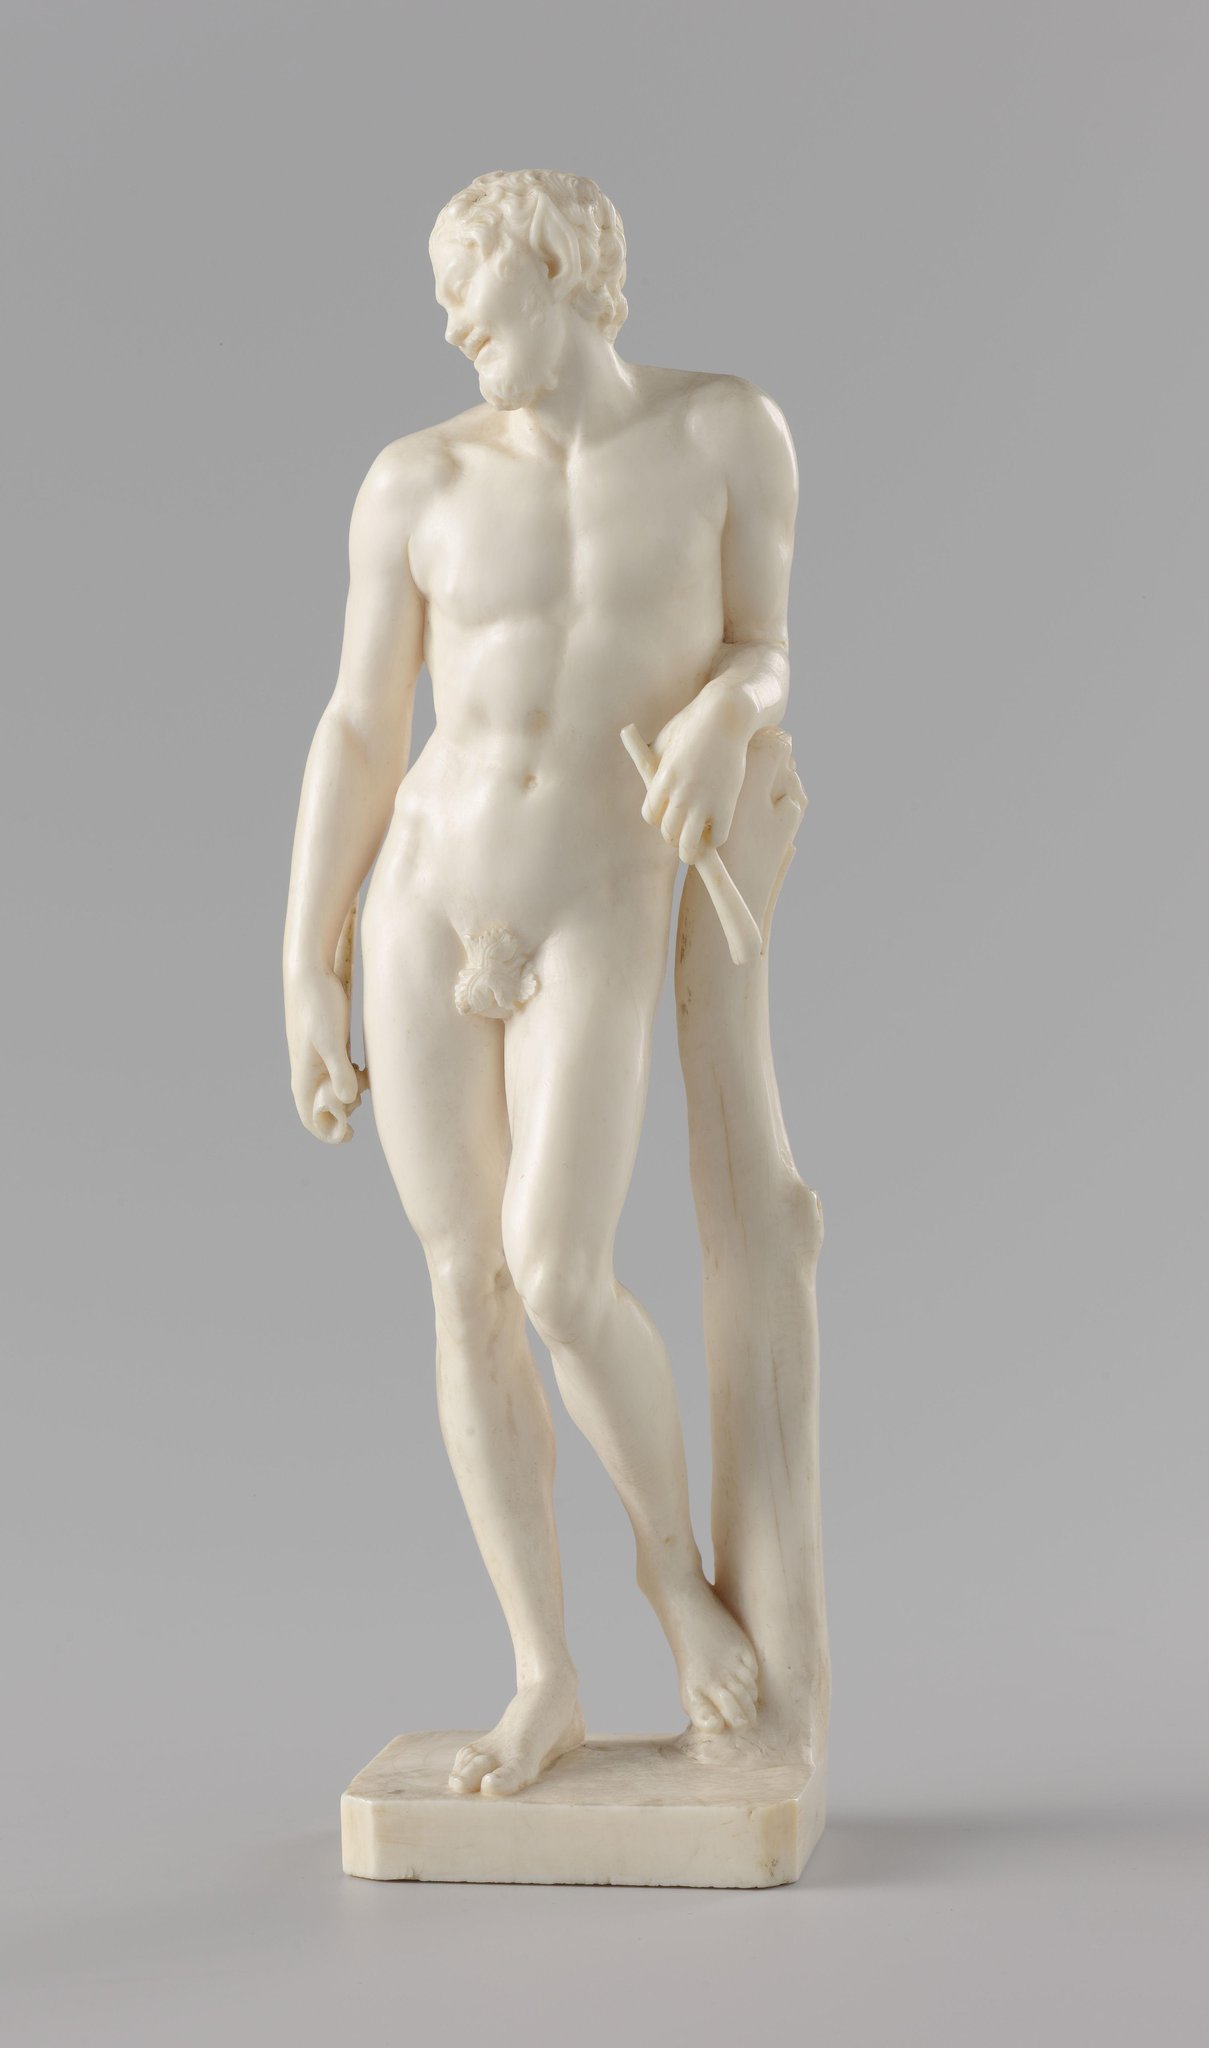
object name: sculpture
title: Nymph and Satyr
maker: jan baptist xavery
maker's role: sculptor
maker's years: 1697-1742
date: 1729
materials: ivory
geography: the hague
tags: satyr(s) (in general)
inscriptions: signature and date, on the back of the plinth, incised: ‘J:B: XAVERY. 1729 F.’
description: Hij staat op het rechterbeen en met het linker gebogen op een rechthoekige plint met afgeschuinde hoeken en met de linkerarm steunt hij op een boomstronk, waartegen hij zijn linkervoet laat rusten. De rechterarm hangt slap langs het lichaam. In elke hand heeft hij een fluit. De naar links gewende kop, die lachend schuin naar beneden kijkt, heeft spitse oren, korte horentjes en bij de baard bokkeklieren. De schaamte wordt bedekt door een druiveblad. Op de rug een staartje.